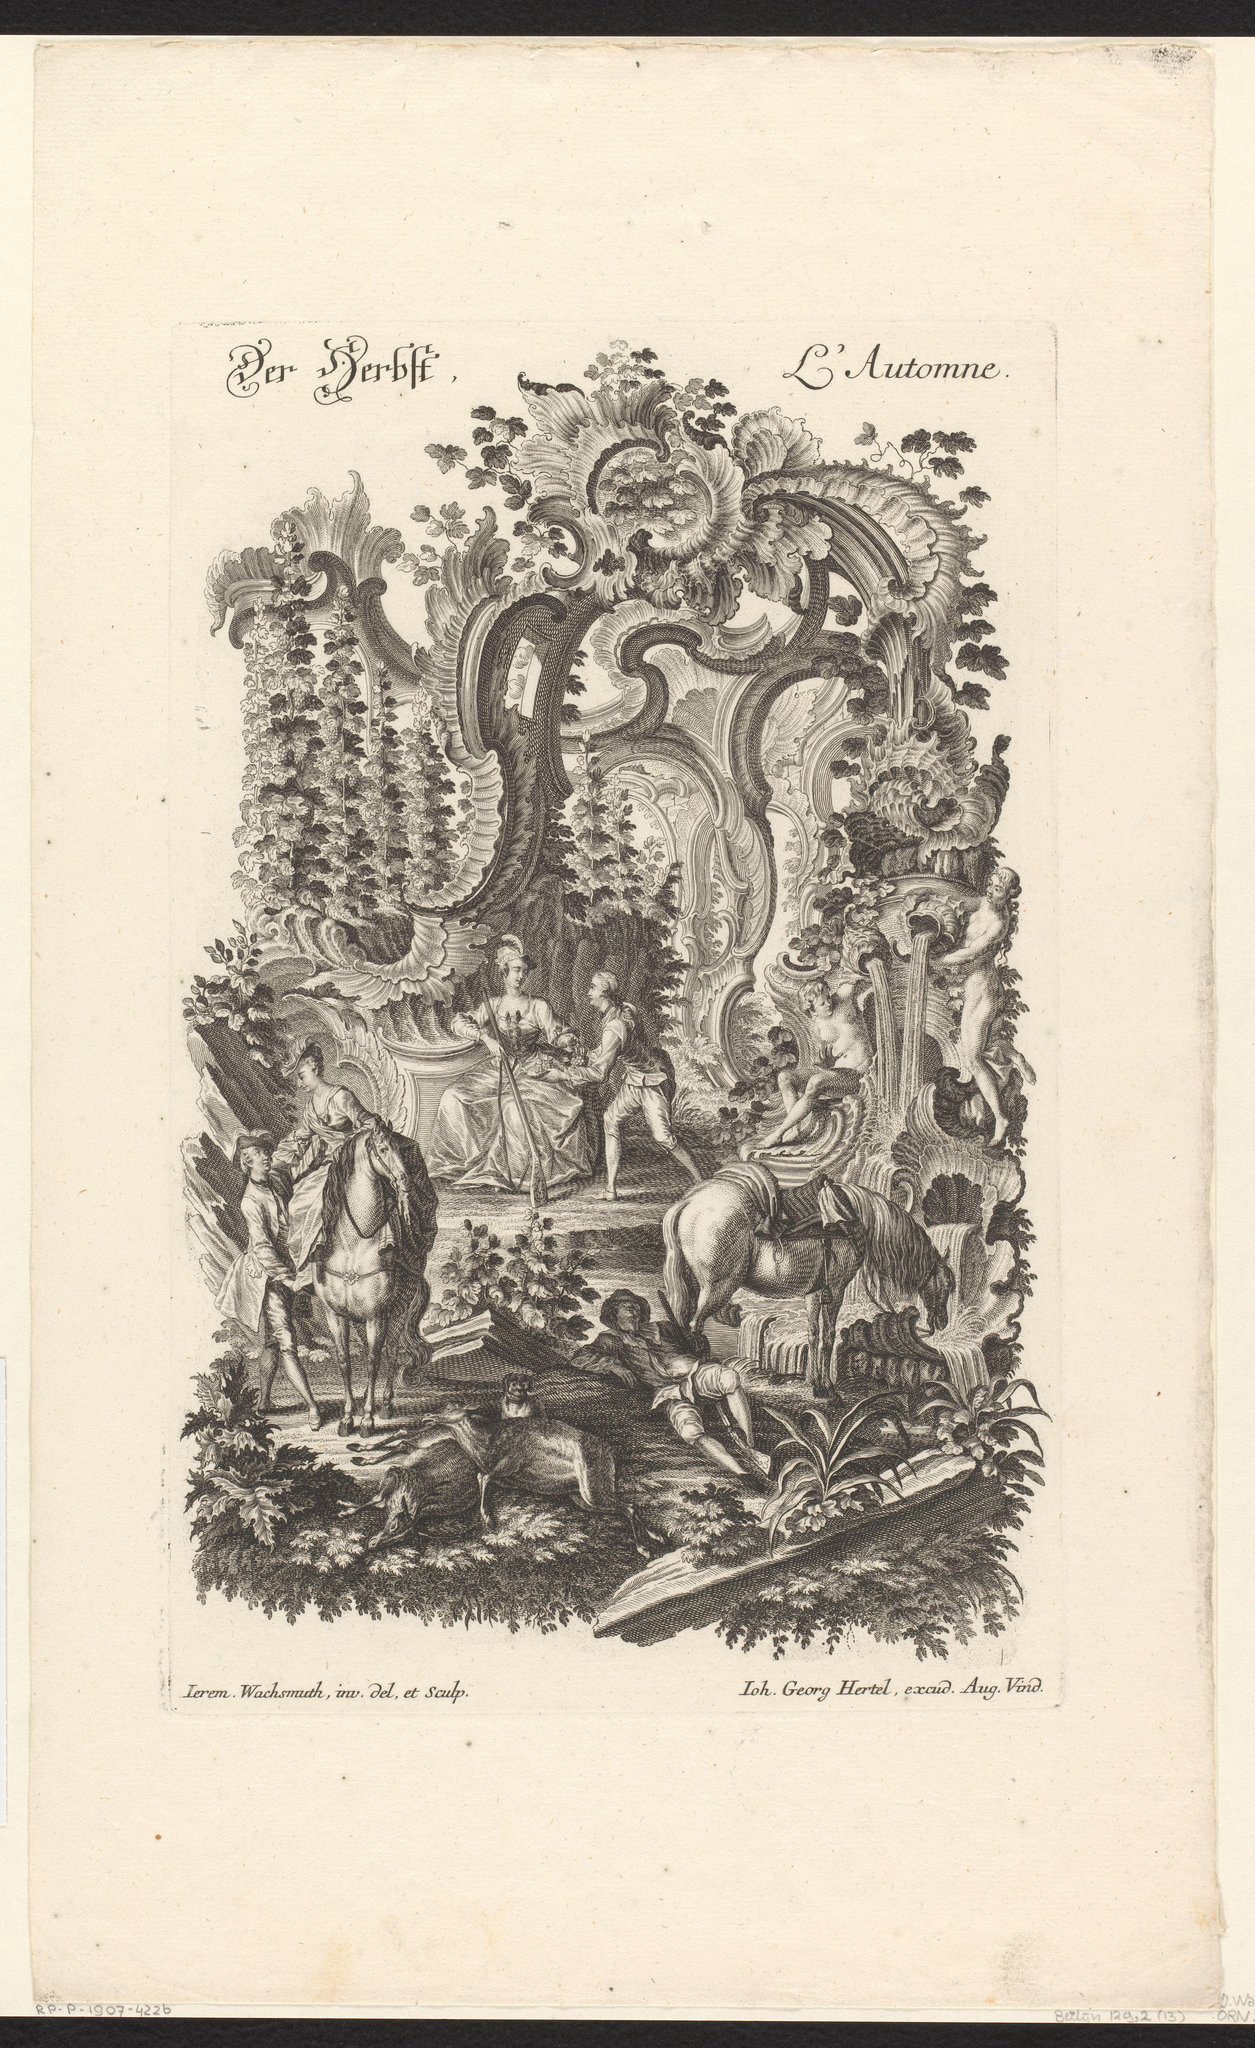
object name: ornament print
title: De vier jaargetijden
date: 1721-1771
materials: paper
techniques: etching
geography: augsburg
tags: spoils of the hunt, game, venison, hunters resting during the hunt, hunter - cc - female hunter, huntress, autumn, fall, 'autumnus'; 'autunno' (ripa)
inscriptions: collector's mark: Lugt 2228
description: Een jongeman brengt een vrouwelijke jager druiven. Rondom een rocaille omlijsting. Rechts ligt een jager te rusten, zijn paard drinkt uit een waterbron. Links helpt een man een vrouw met afstijgen. In de voorgrond staat een hond bij een jachtbuit.